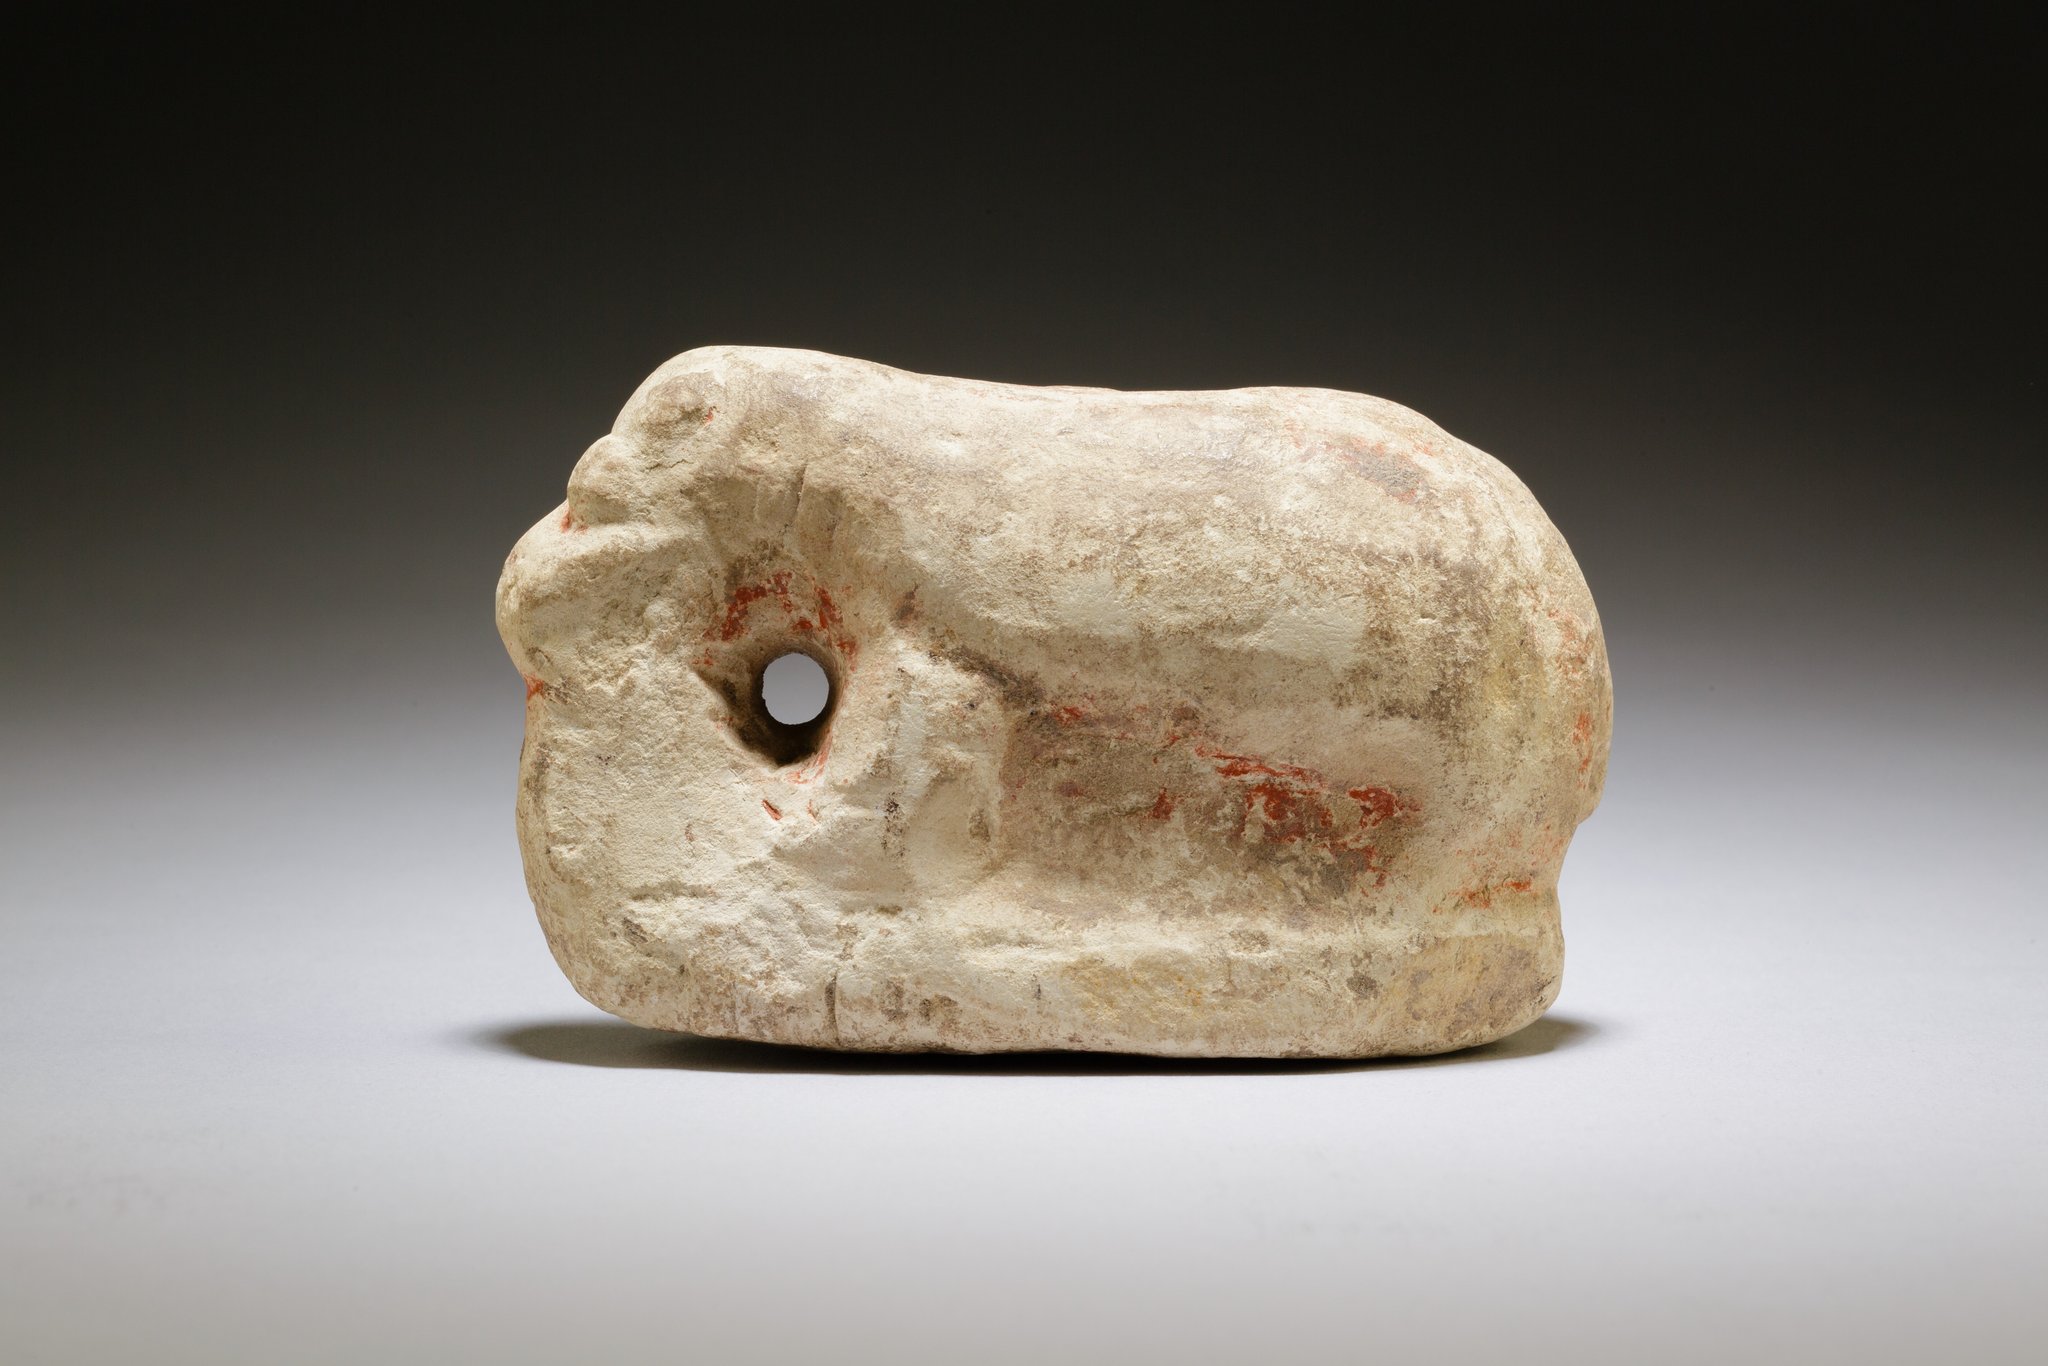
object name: figurine, hippopotamus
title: Figurine of hippopotamus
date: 1981-1640 BCE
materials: limestone, paint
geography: egypt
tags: hippos